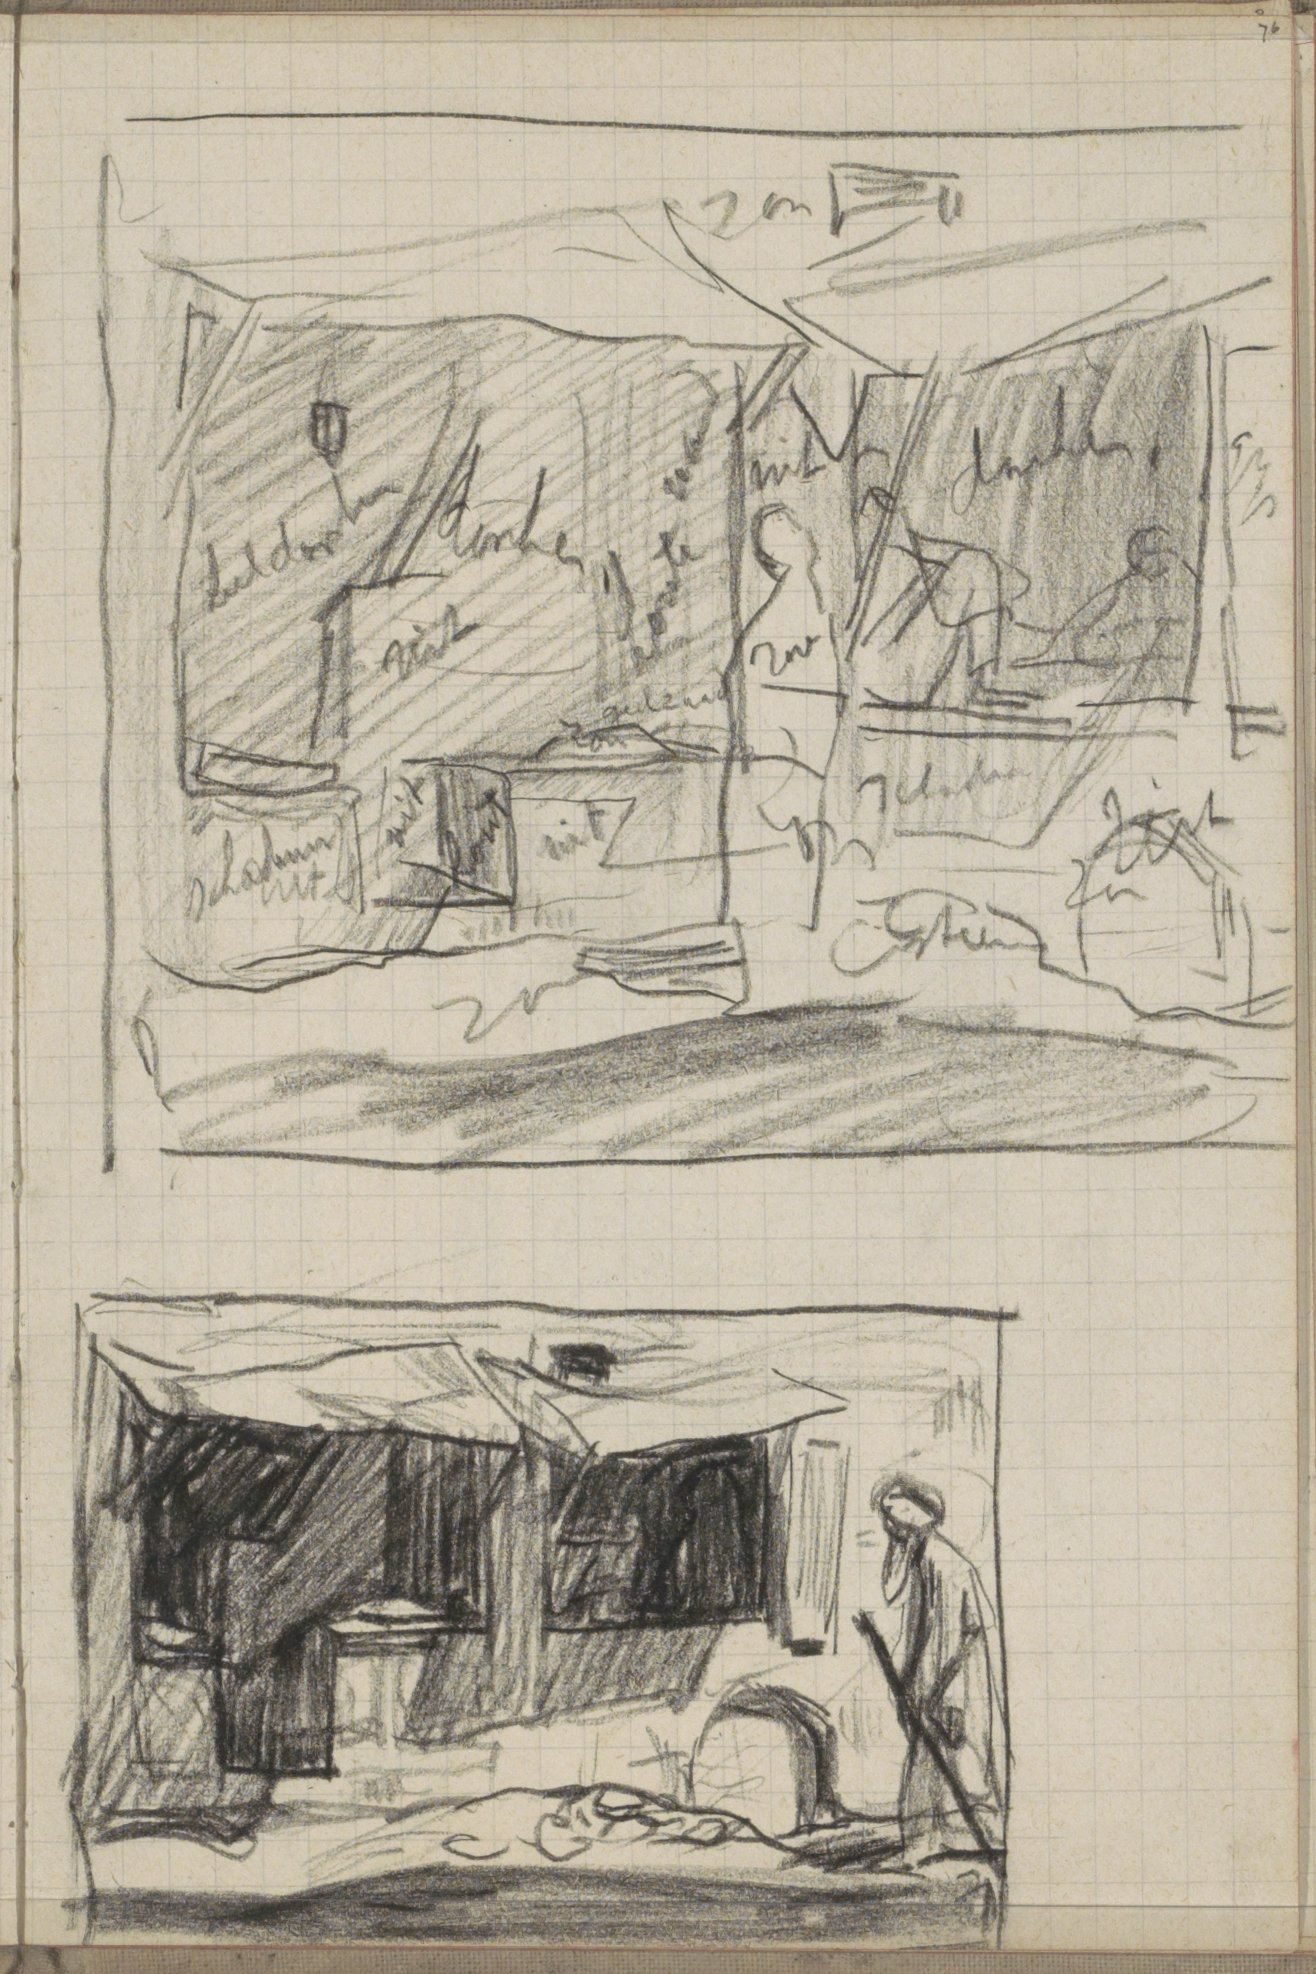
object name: sketchbook leaf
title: Figuren in een straat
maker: marius bauer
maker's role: draughtsman, print maker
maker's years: 1867-1932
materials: chalk, paper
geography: istanbul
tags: street (+ city(-scape) with figures, staffage)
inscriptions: kleurnotitie, handgeschreven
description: De figuren zitten, staan of lopen. Pagina 76 uit een schetsboek met 51 bladen.